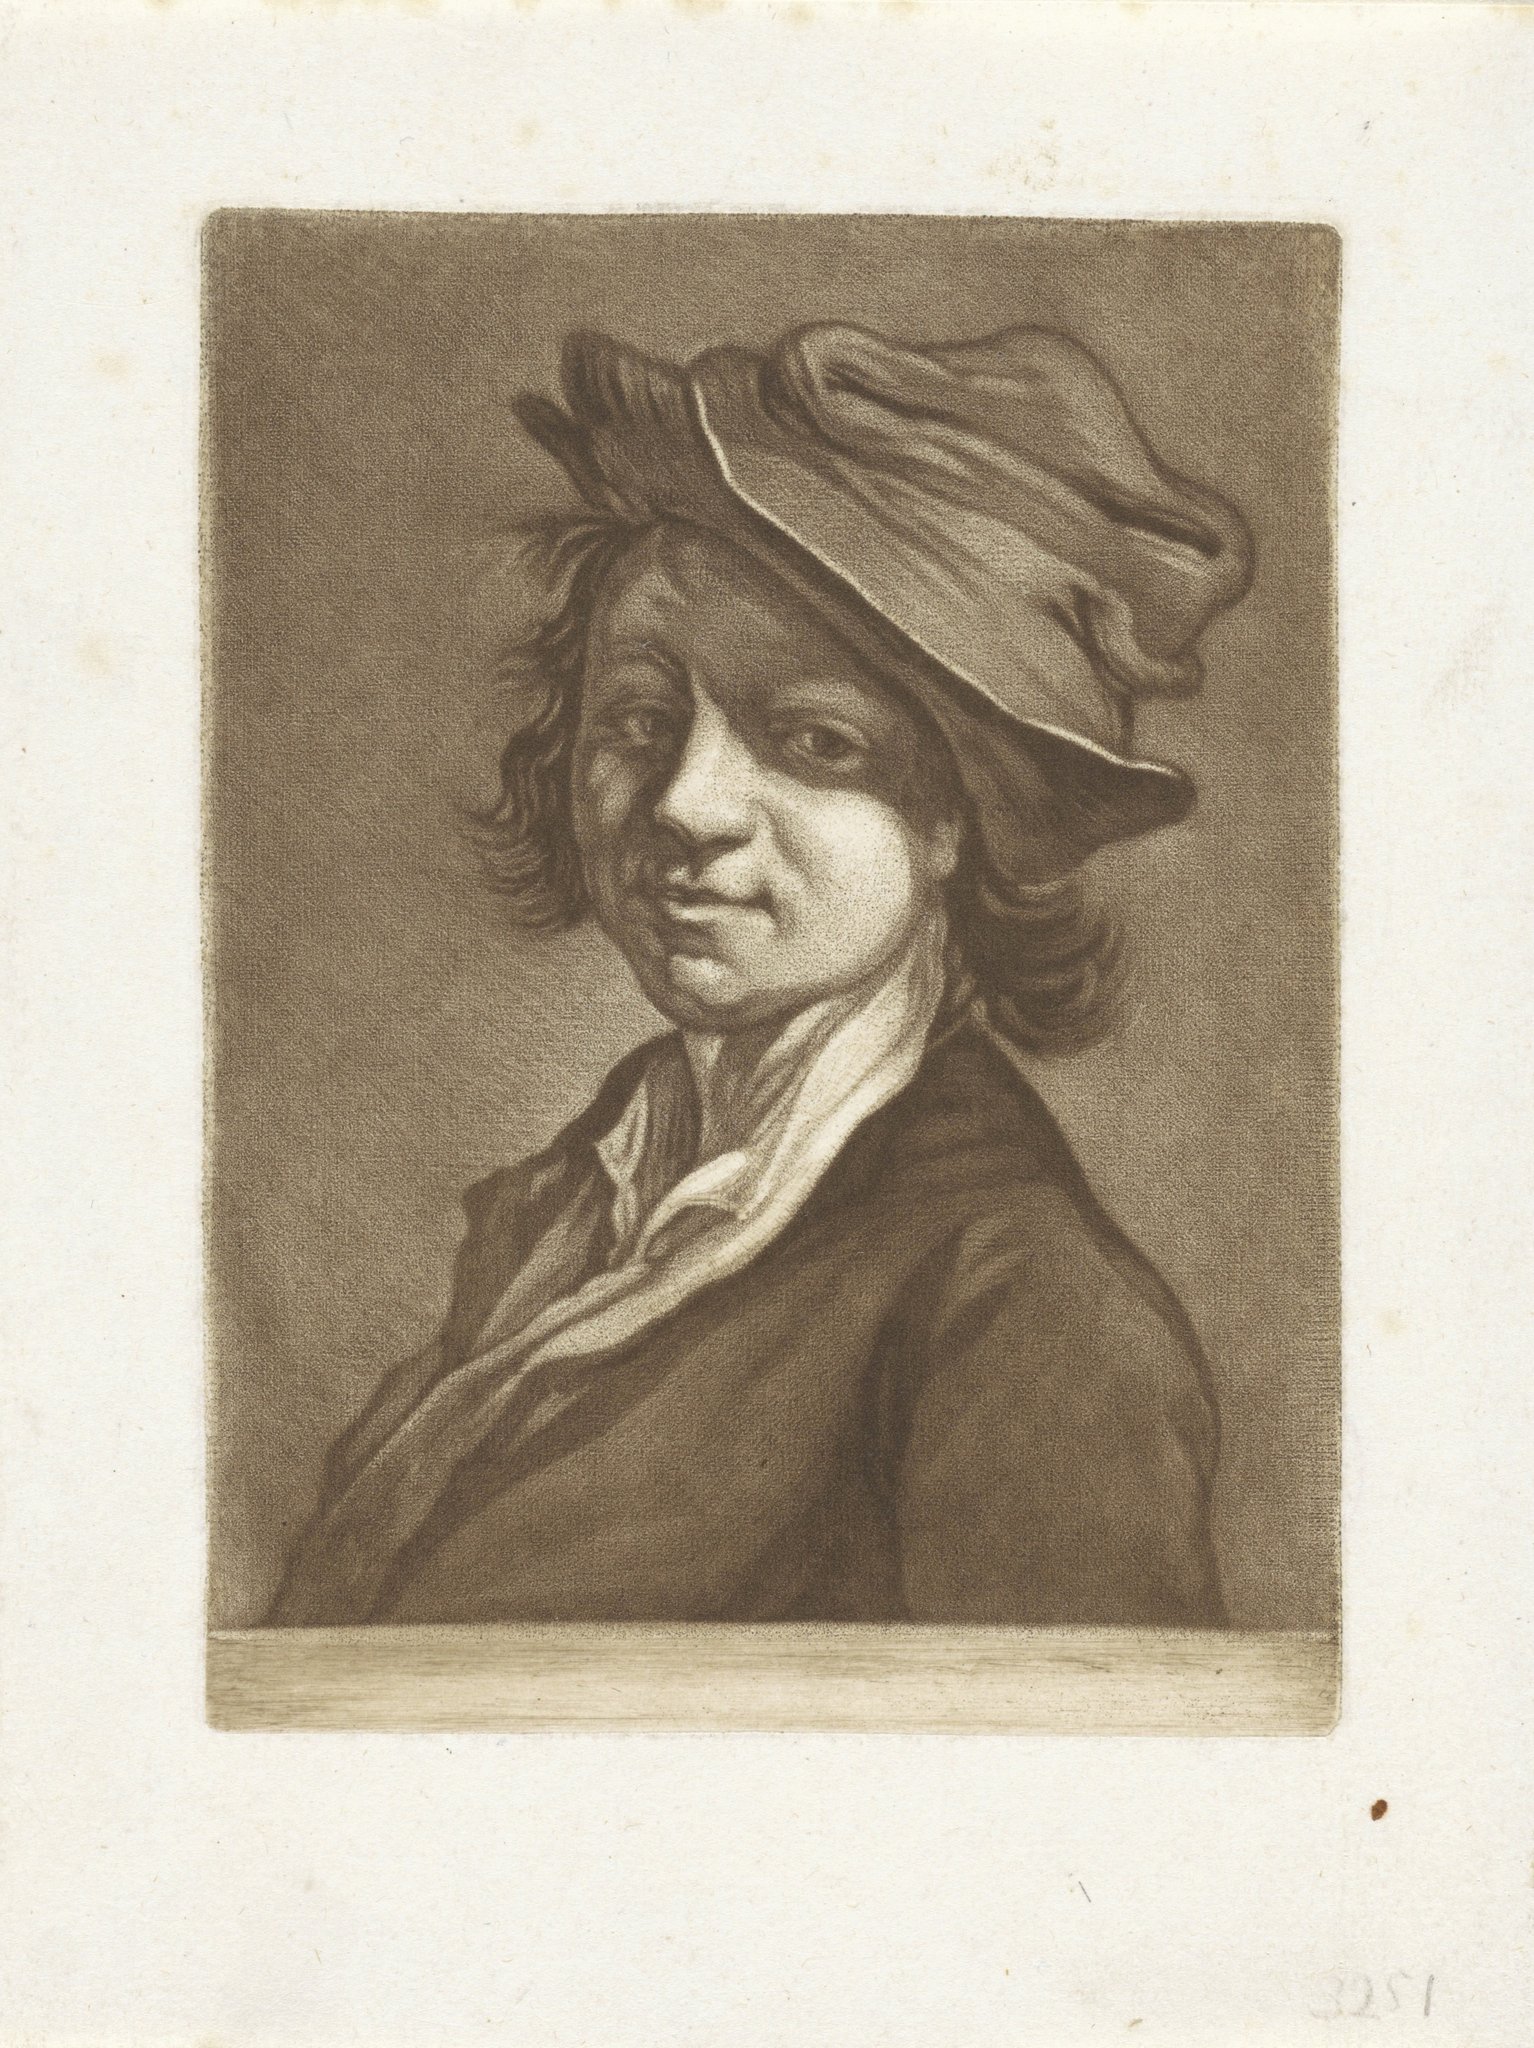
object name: print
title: Jongen met een hoed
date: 1740-1774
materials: paper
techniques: mezzotint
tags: head-gear: hat (+ men's clothes)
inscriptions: collector's mark: Lugt 240